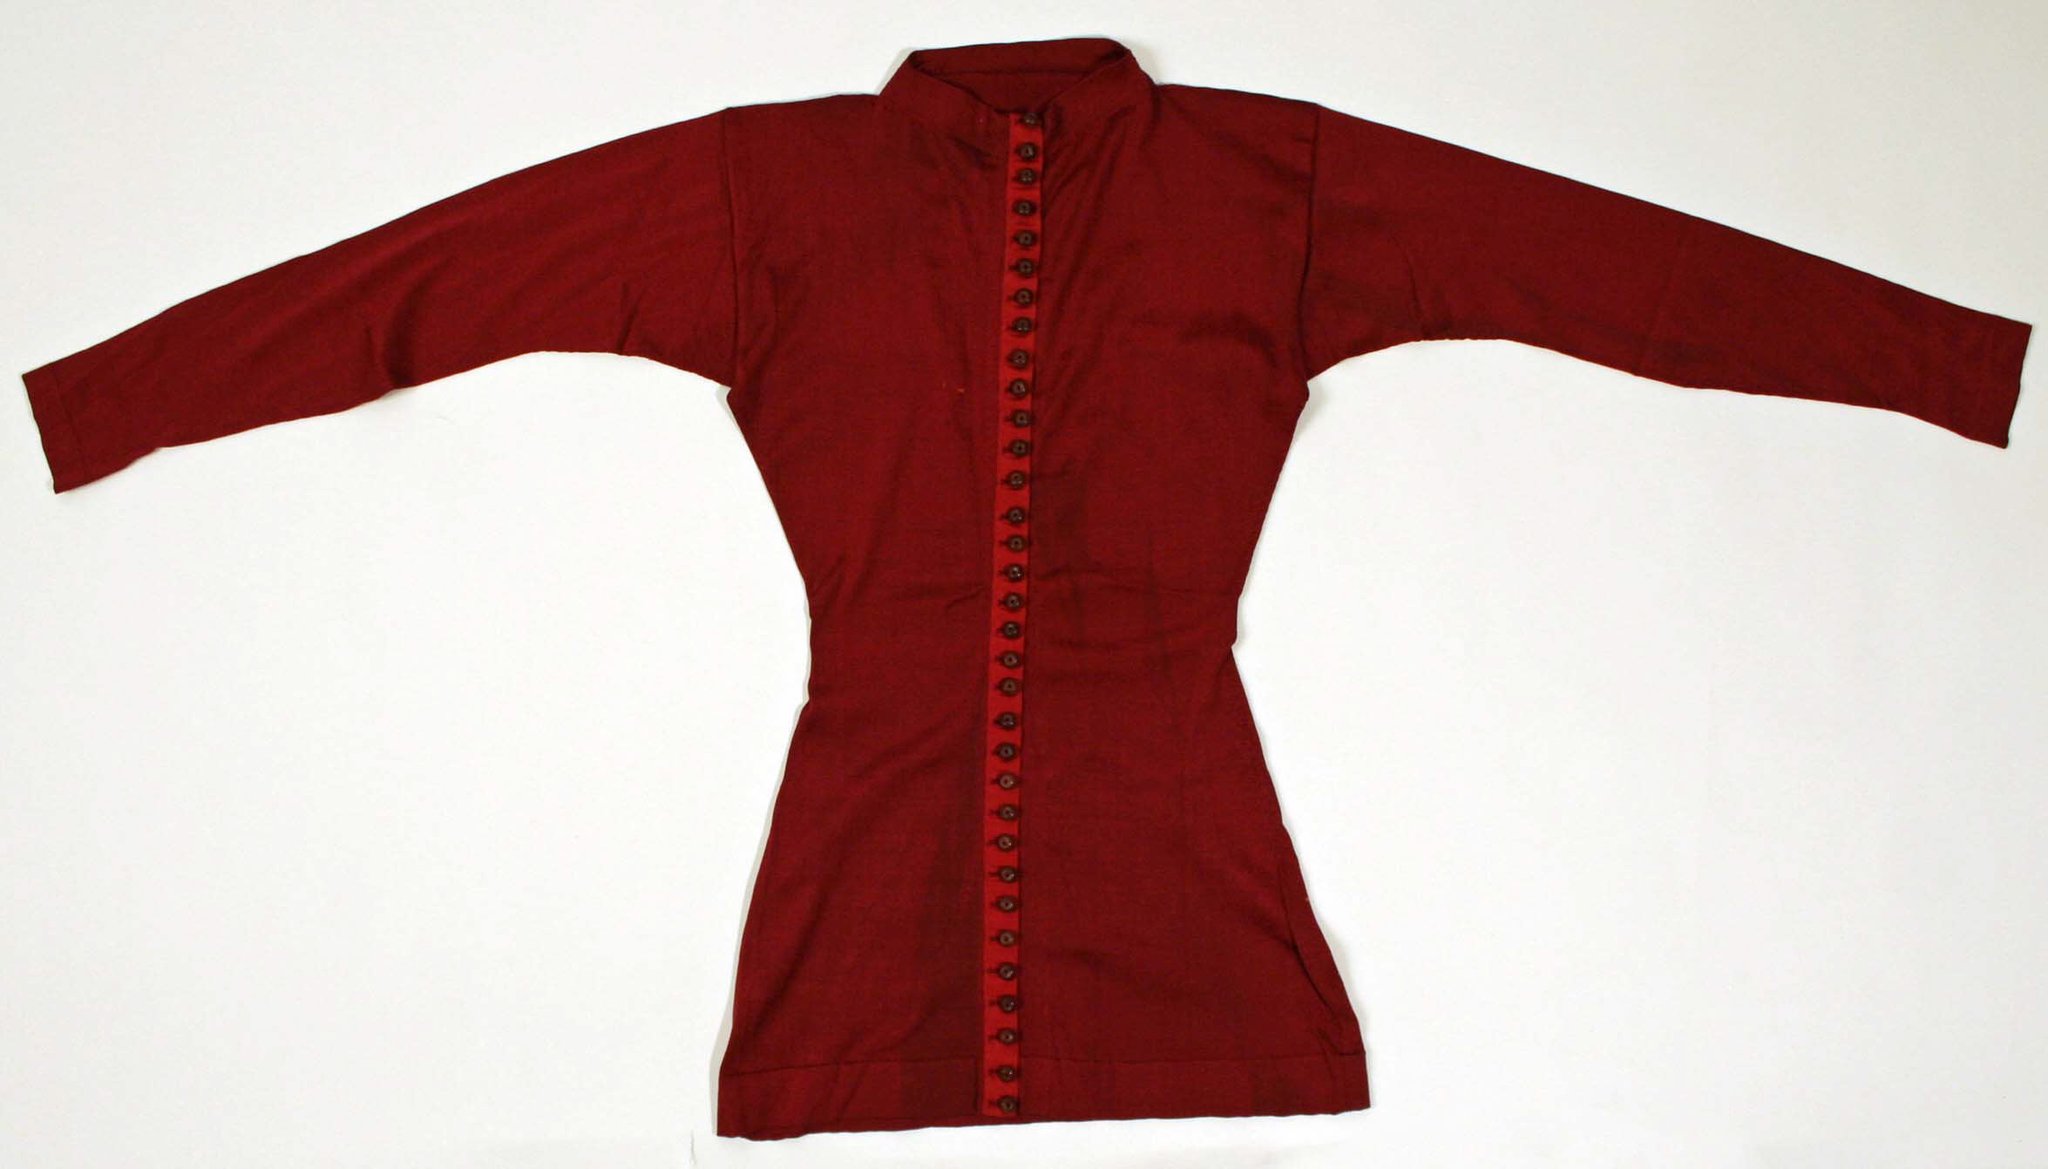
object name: sweater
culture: american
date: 1880-1889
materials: silk, wood